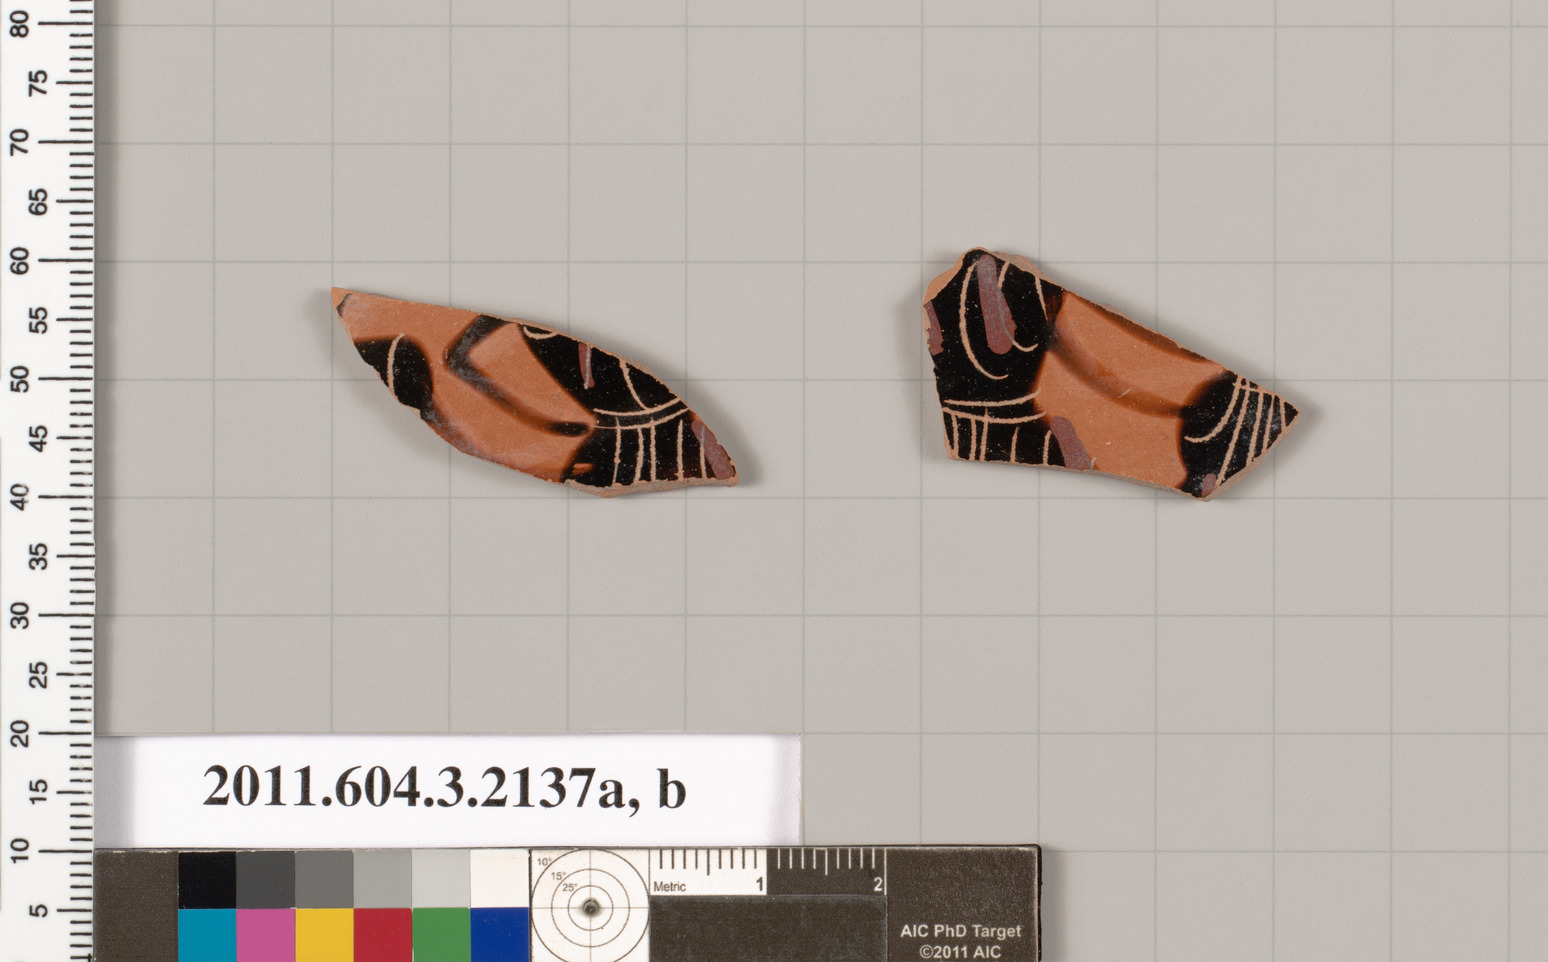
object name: kylix fragment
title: Terracotta fragments of a kylix (drinking cup)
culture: greek, attic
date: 534-468 BCE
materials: terracotta